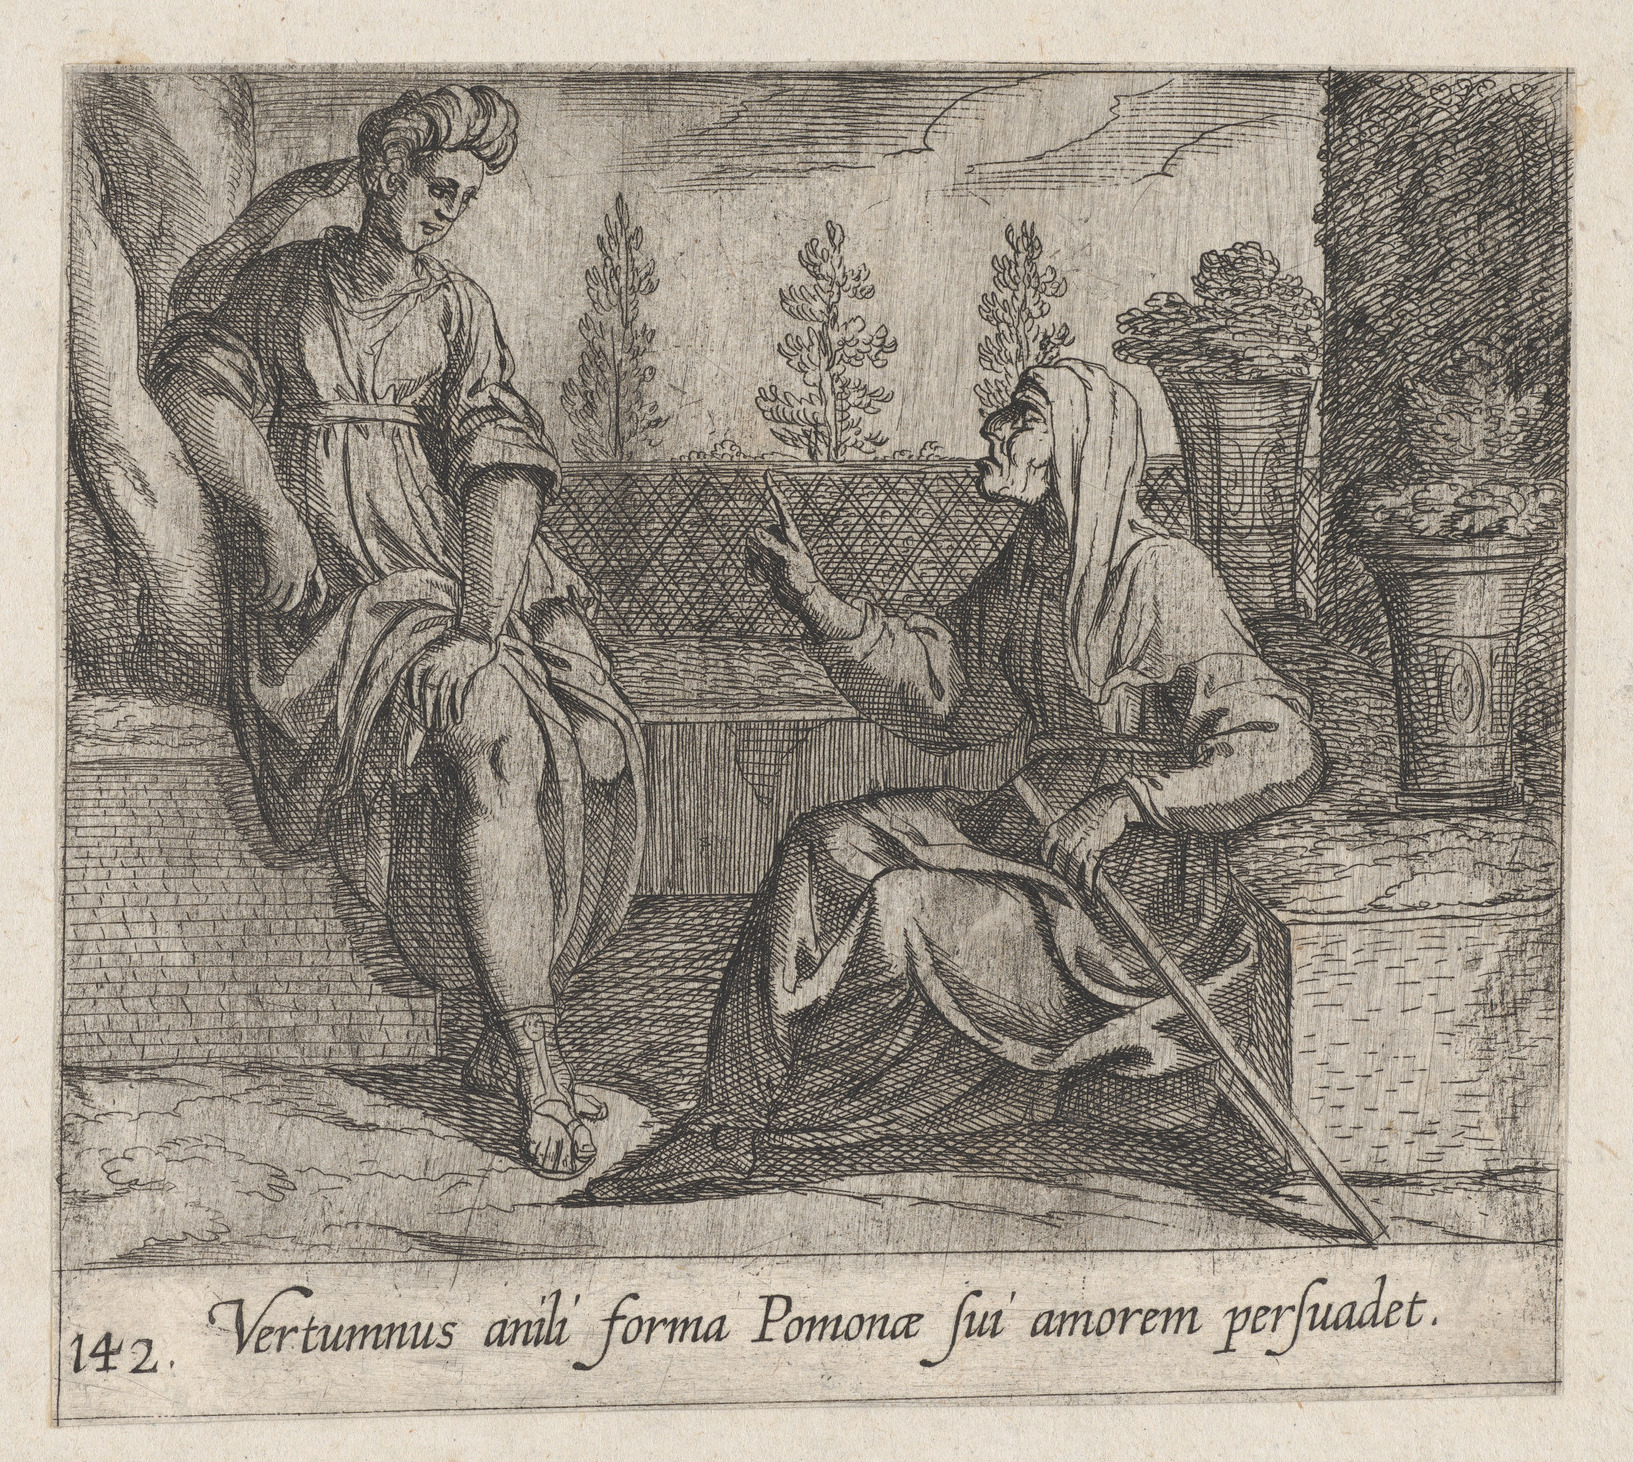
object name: print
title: Plate 142: Pomona and Vertumnus (Vertumnus anili forma Pomonae sui amorem persuadet), from Ovid's 'Metamorphoses'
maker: antonio tempesta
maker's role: artist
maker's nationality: italian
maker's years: 1555-1630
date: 1606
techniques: etching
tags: women